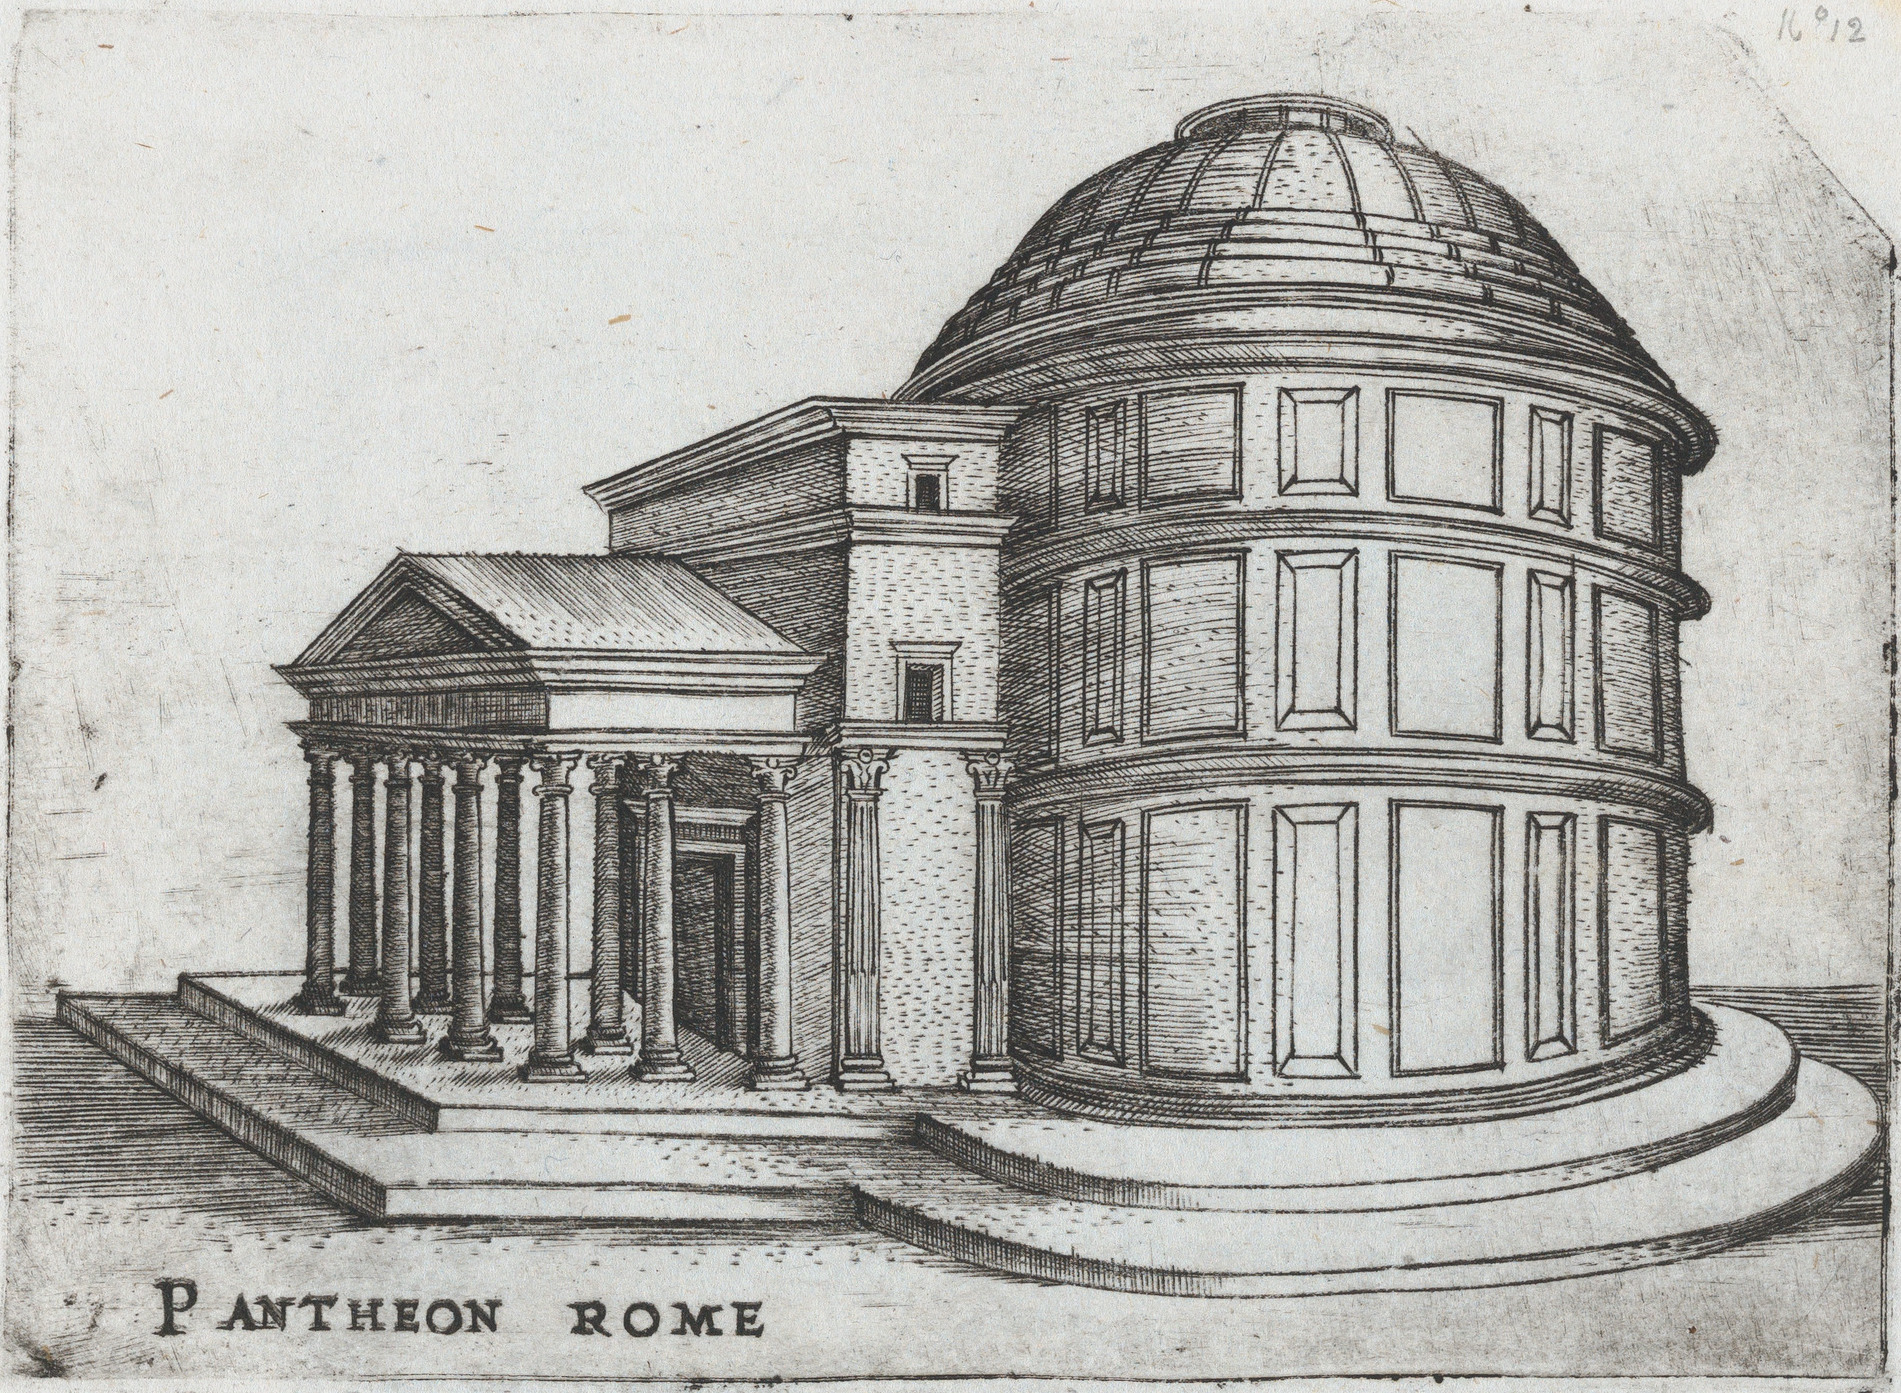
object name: album print ornament architecture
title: Arcus in Hispania, from a Series of Prints depicting (reconstructed) Buildings from Roman Antiquity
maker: monogrammist g.a. with the caltrop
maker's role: artist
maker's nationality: italian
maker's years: 1535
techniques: engraving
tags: architecture,buildings